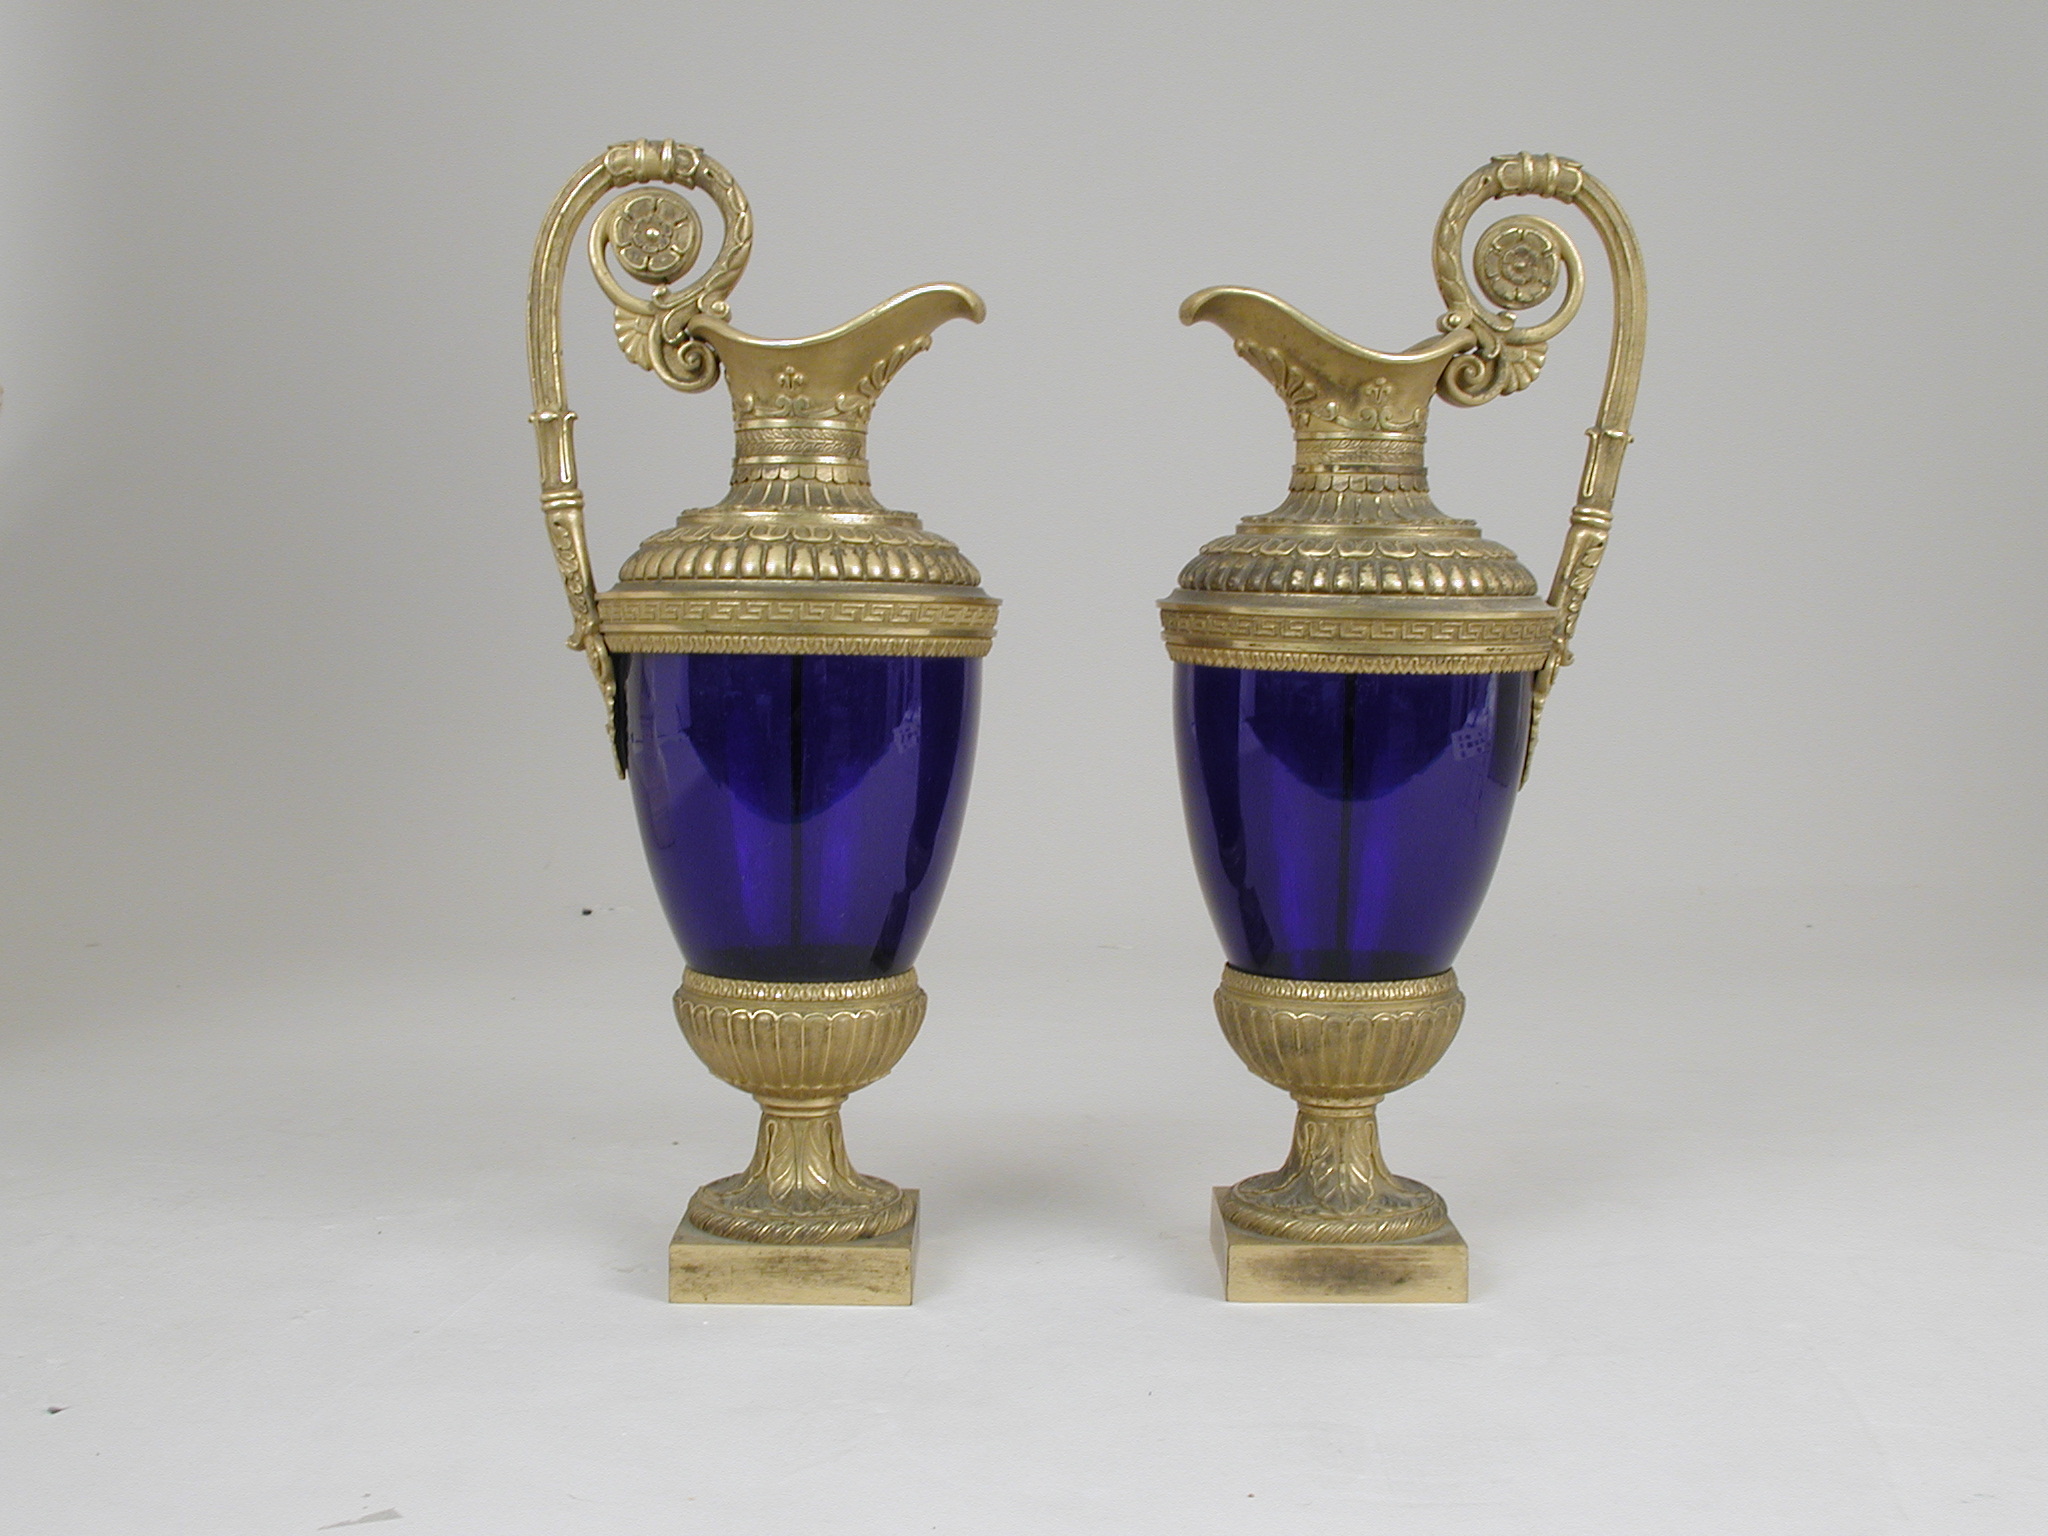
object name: ewer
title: Pair of ewers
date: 1815-1830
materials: gilt bronze, glass